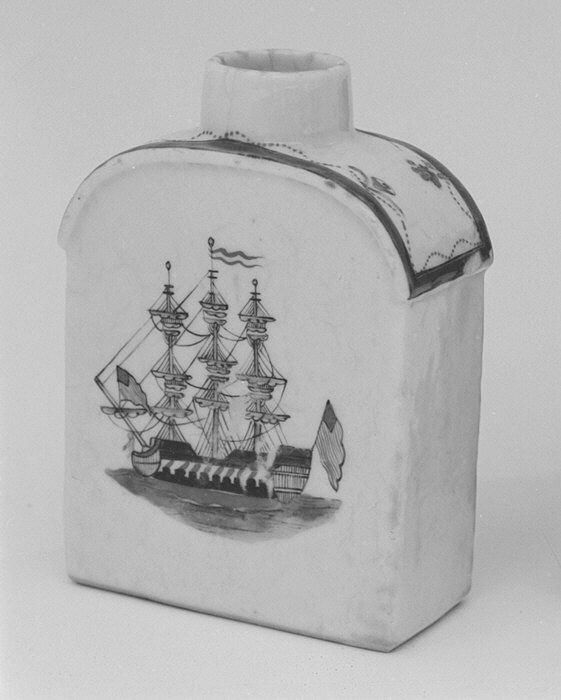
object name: tea caddy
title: Tea caddy (part of a service)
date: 1795-1800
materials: hard paste porcelain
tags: ships